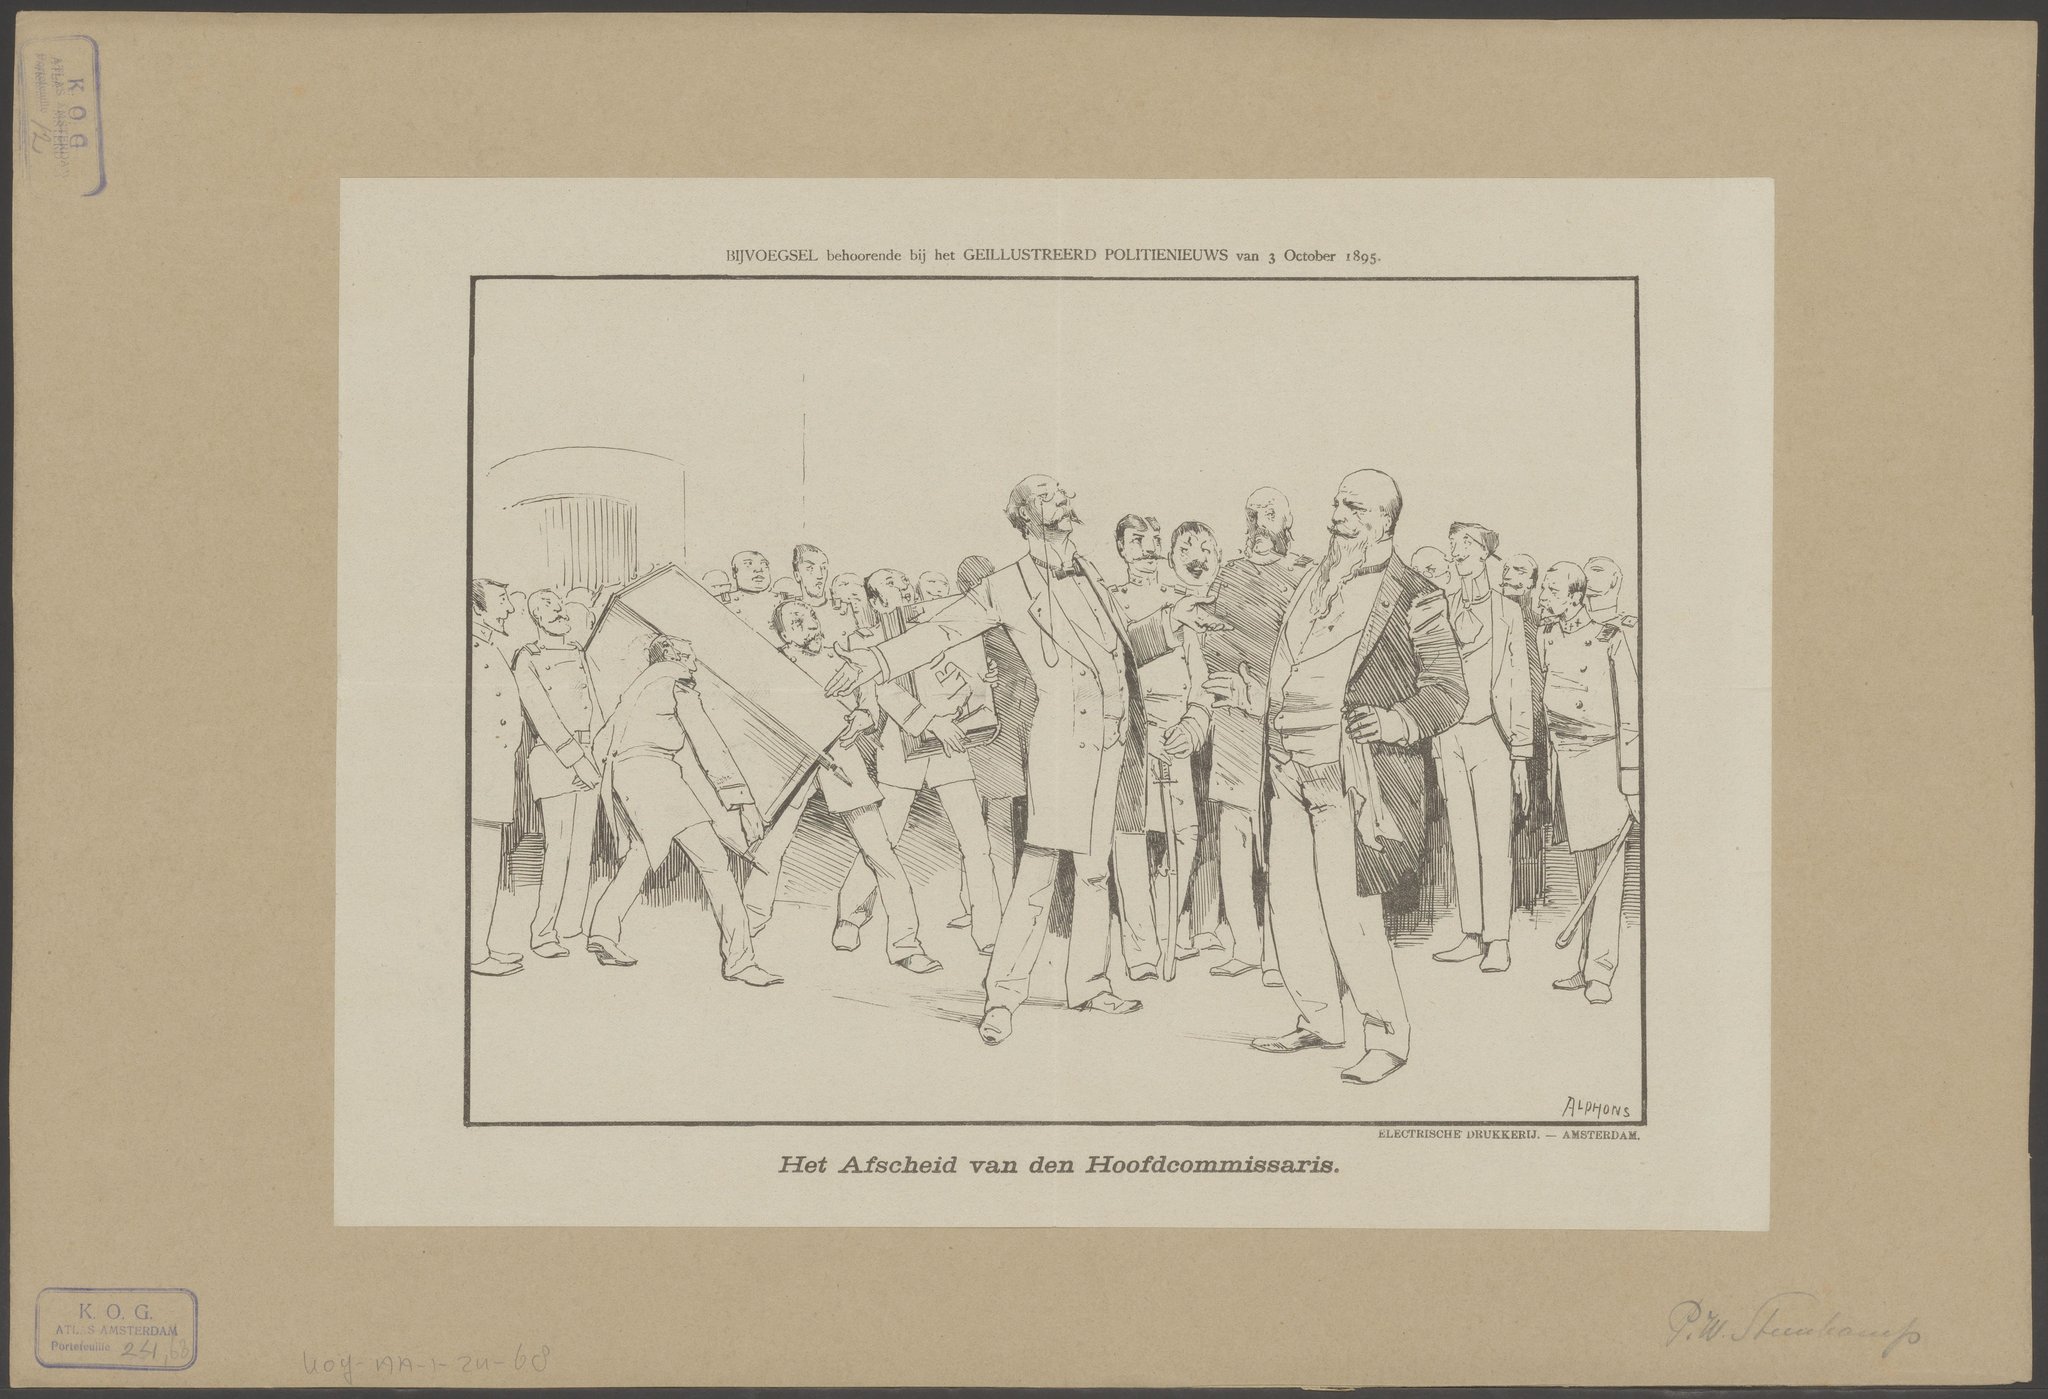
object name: cartoon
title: Het Afscheid van den Hoofdcommissaris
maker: alphons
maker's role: print maker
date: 1895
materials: paper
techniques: letterpress printing, lithograph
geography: netherlands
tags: crowd, mob, safe, strongbox, amsterdam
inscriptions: collector's mark: Lugt 1641b, collector's mark: Lugt 1641b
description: Gepubliceerd als bijvoegsel van 'Het Geïllustreerd Politienieuws', 3 oktober 1895.